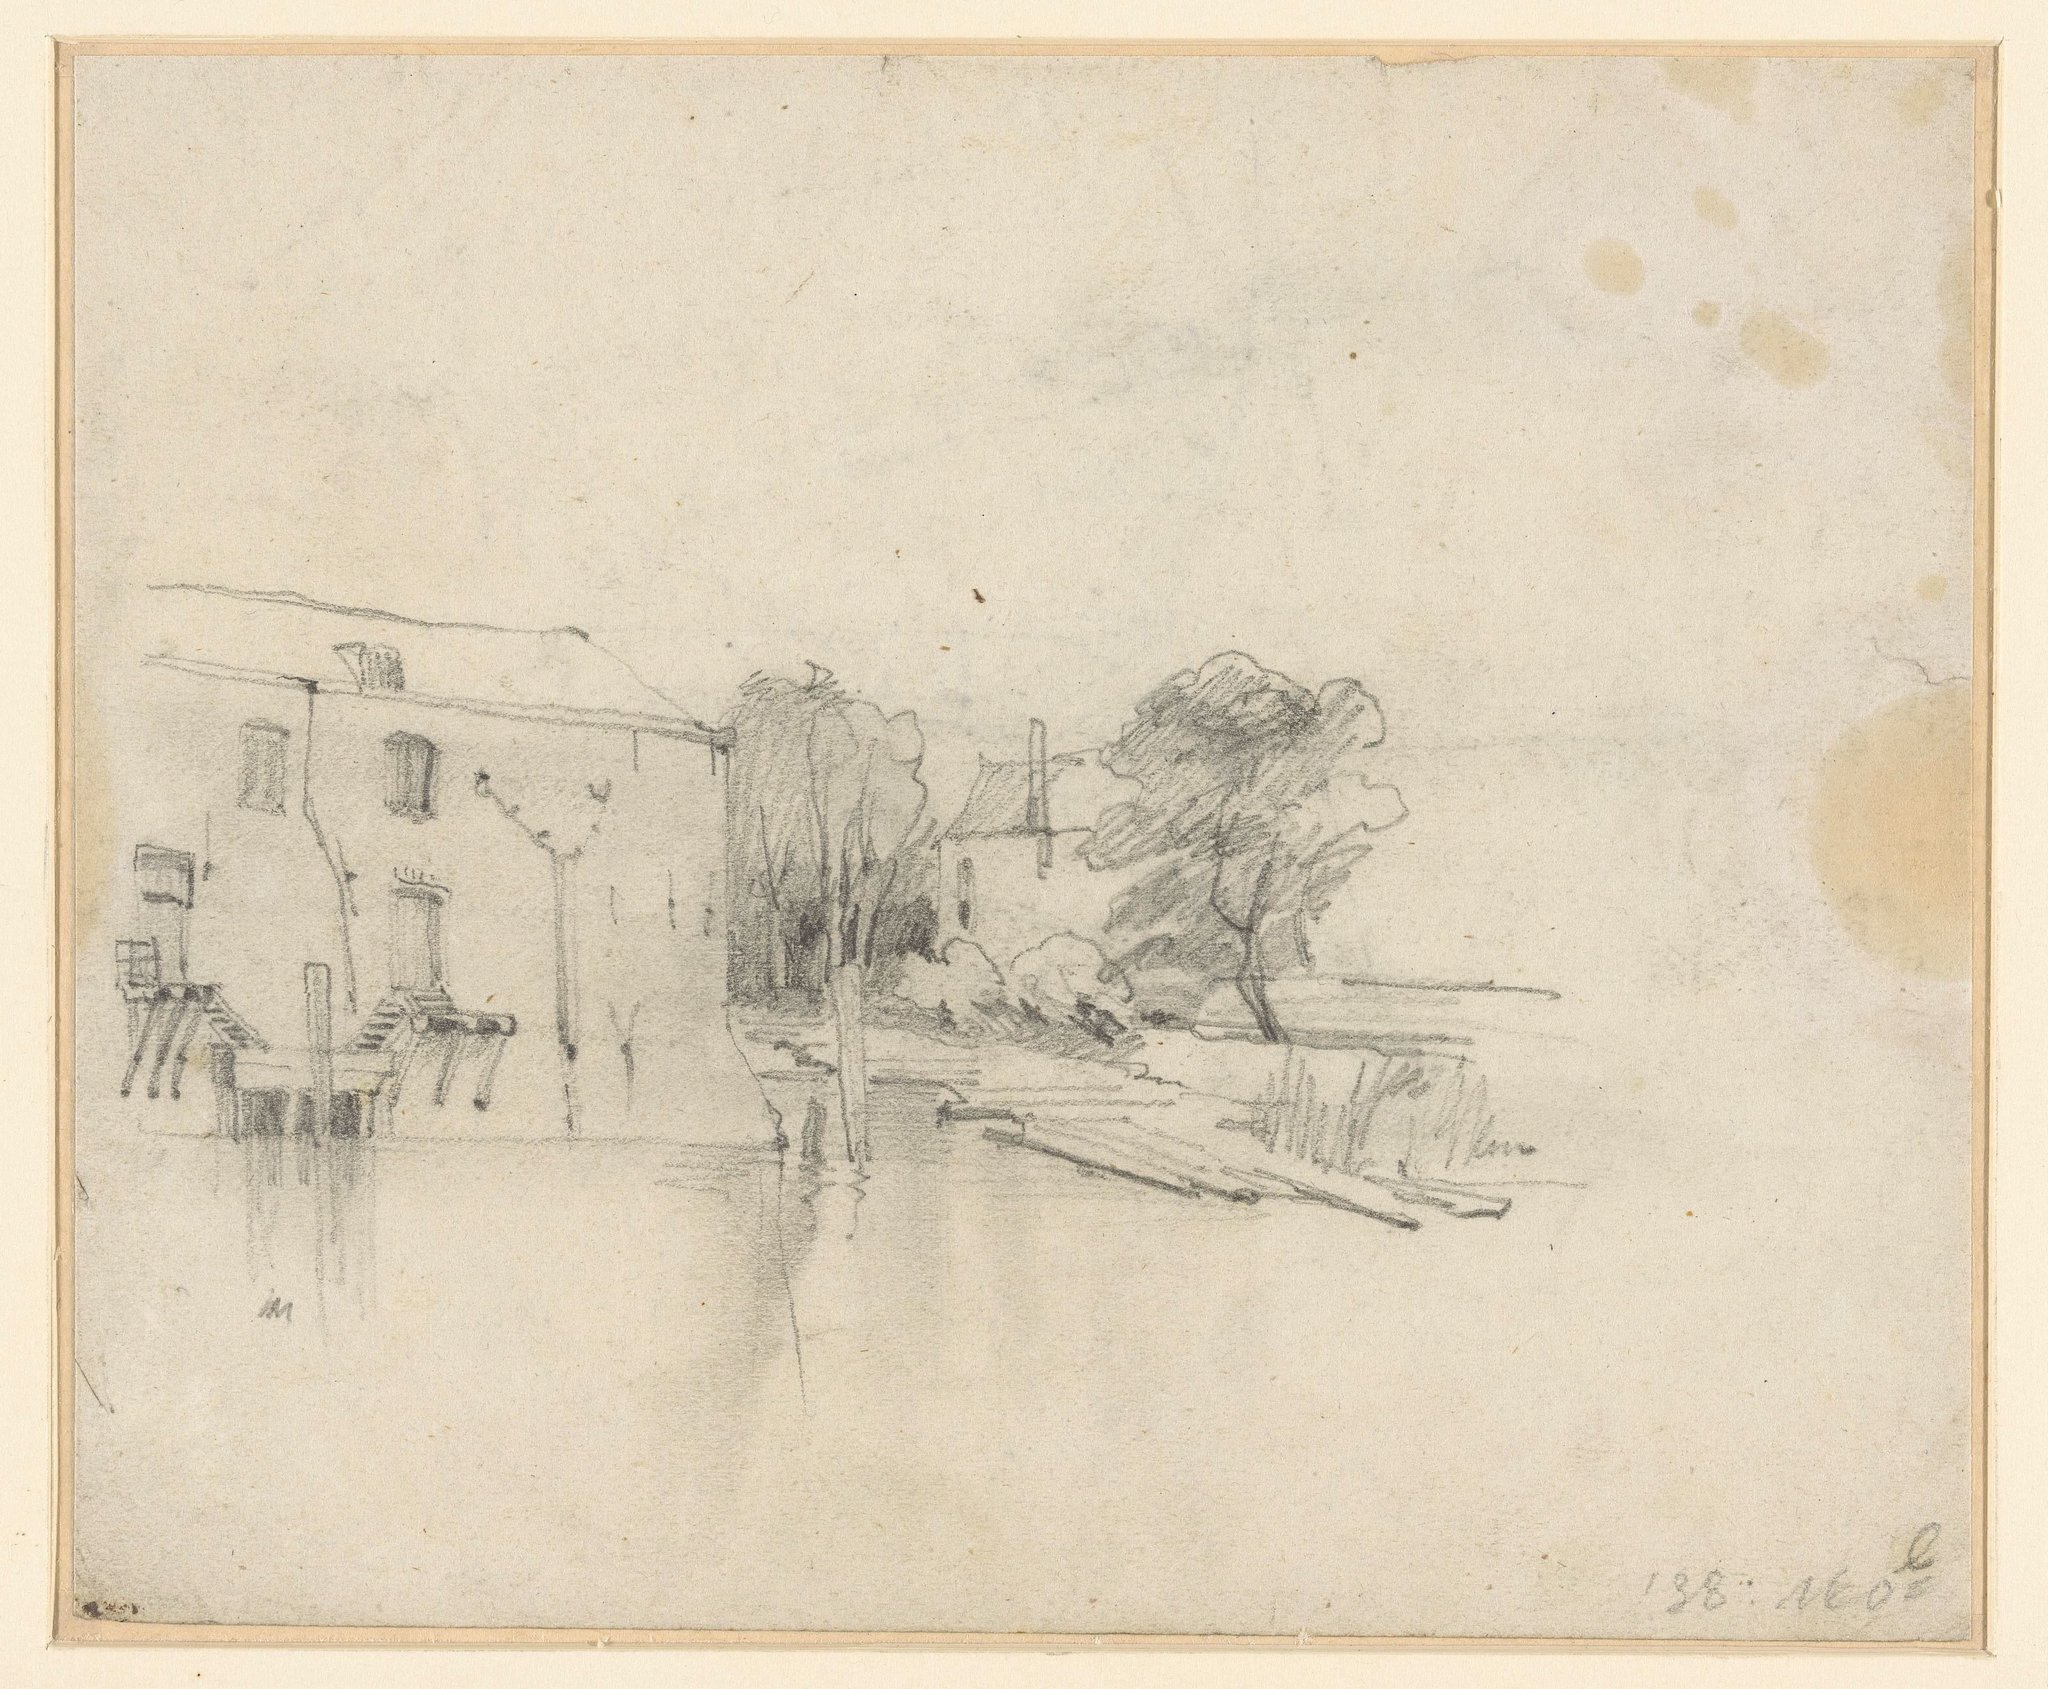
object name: drawing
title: Huizen aan een kanaal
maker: jan weissenbruch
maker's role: painter, print maker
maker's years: 1822-1880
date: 1832-1880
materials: paper, pencil